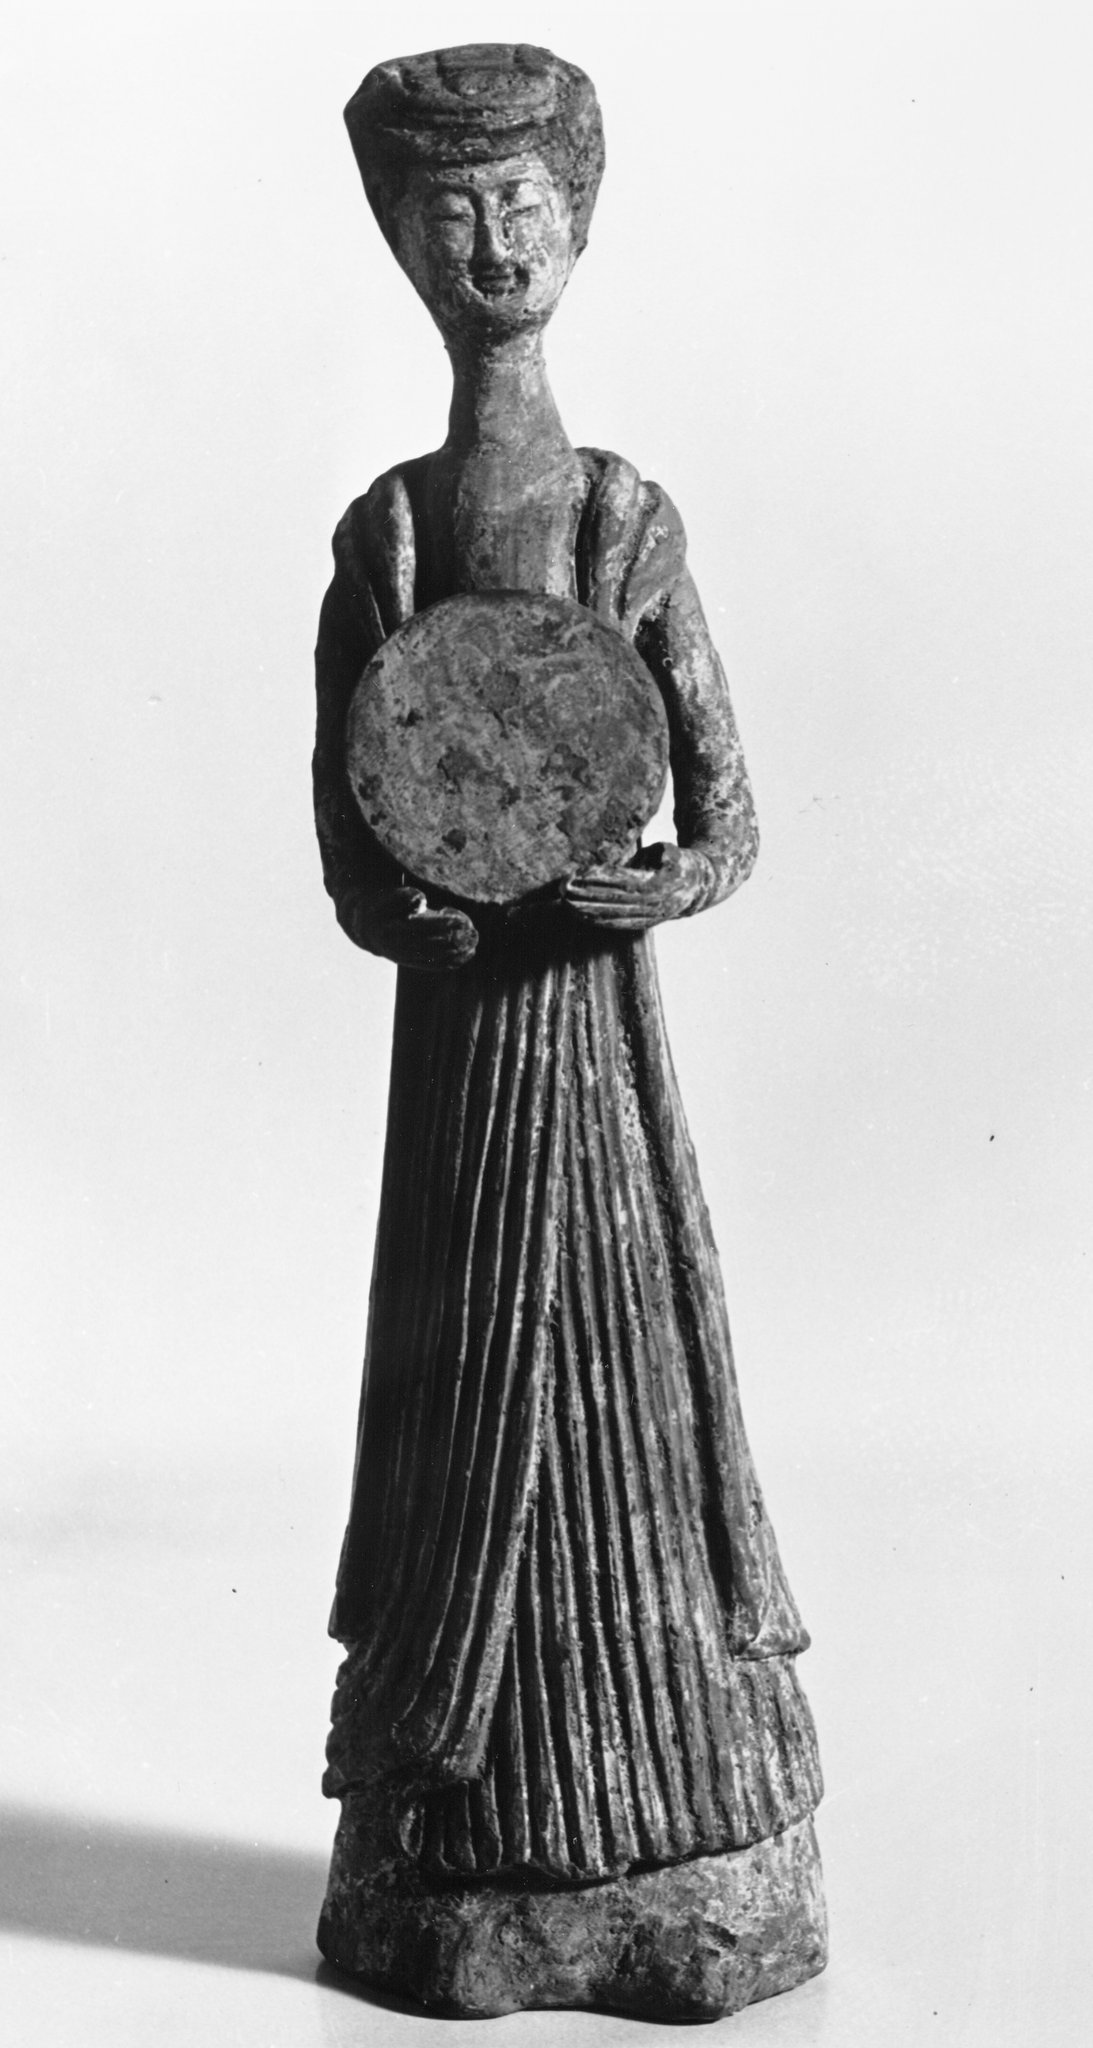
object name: figure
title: Female musician with a drum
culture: chinese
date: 501-600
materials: earthenware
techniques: polychrome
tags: women